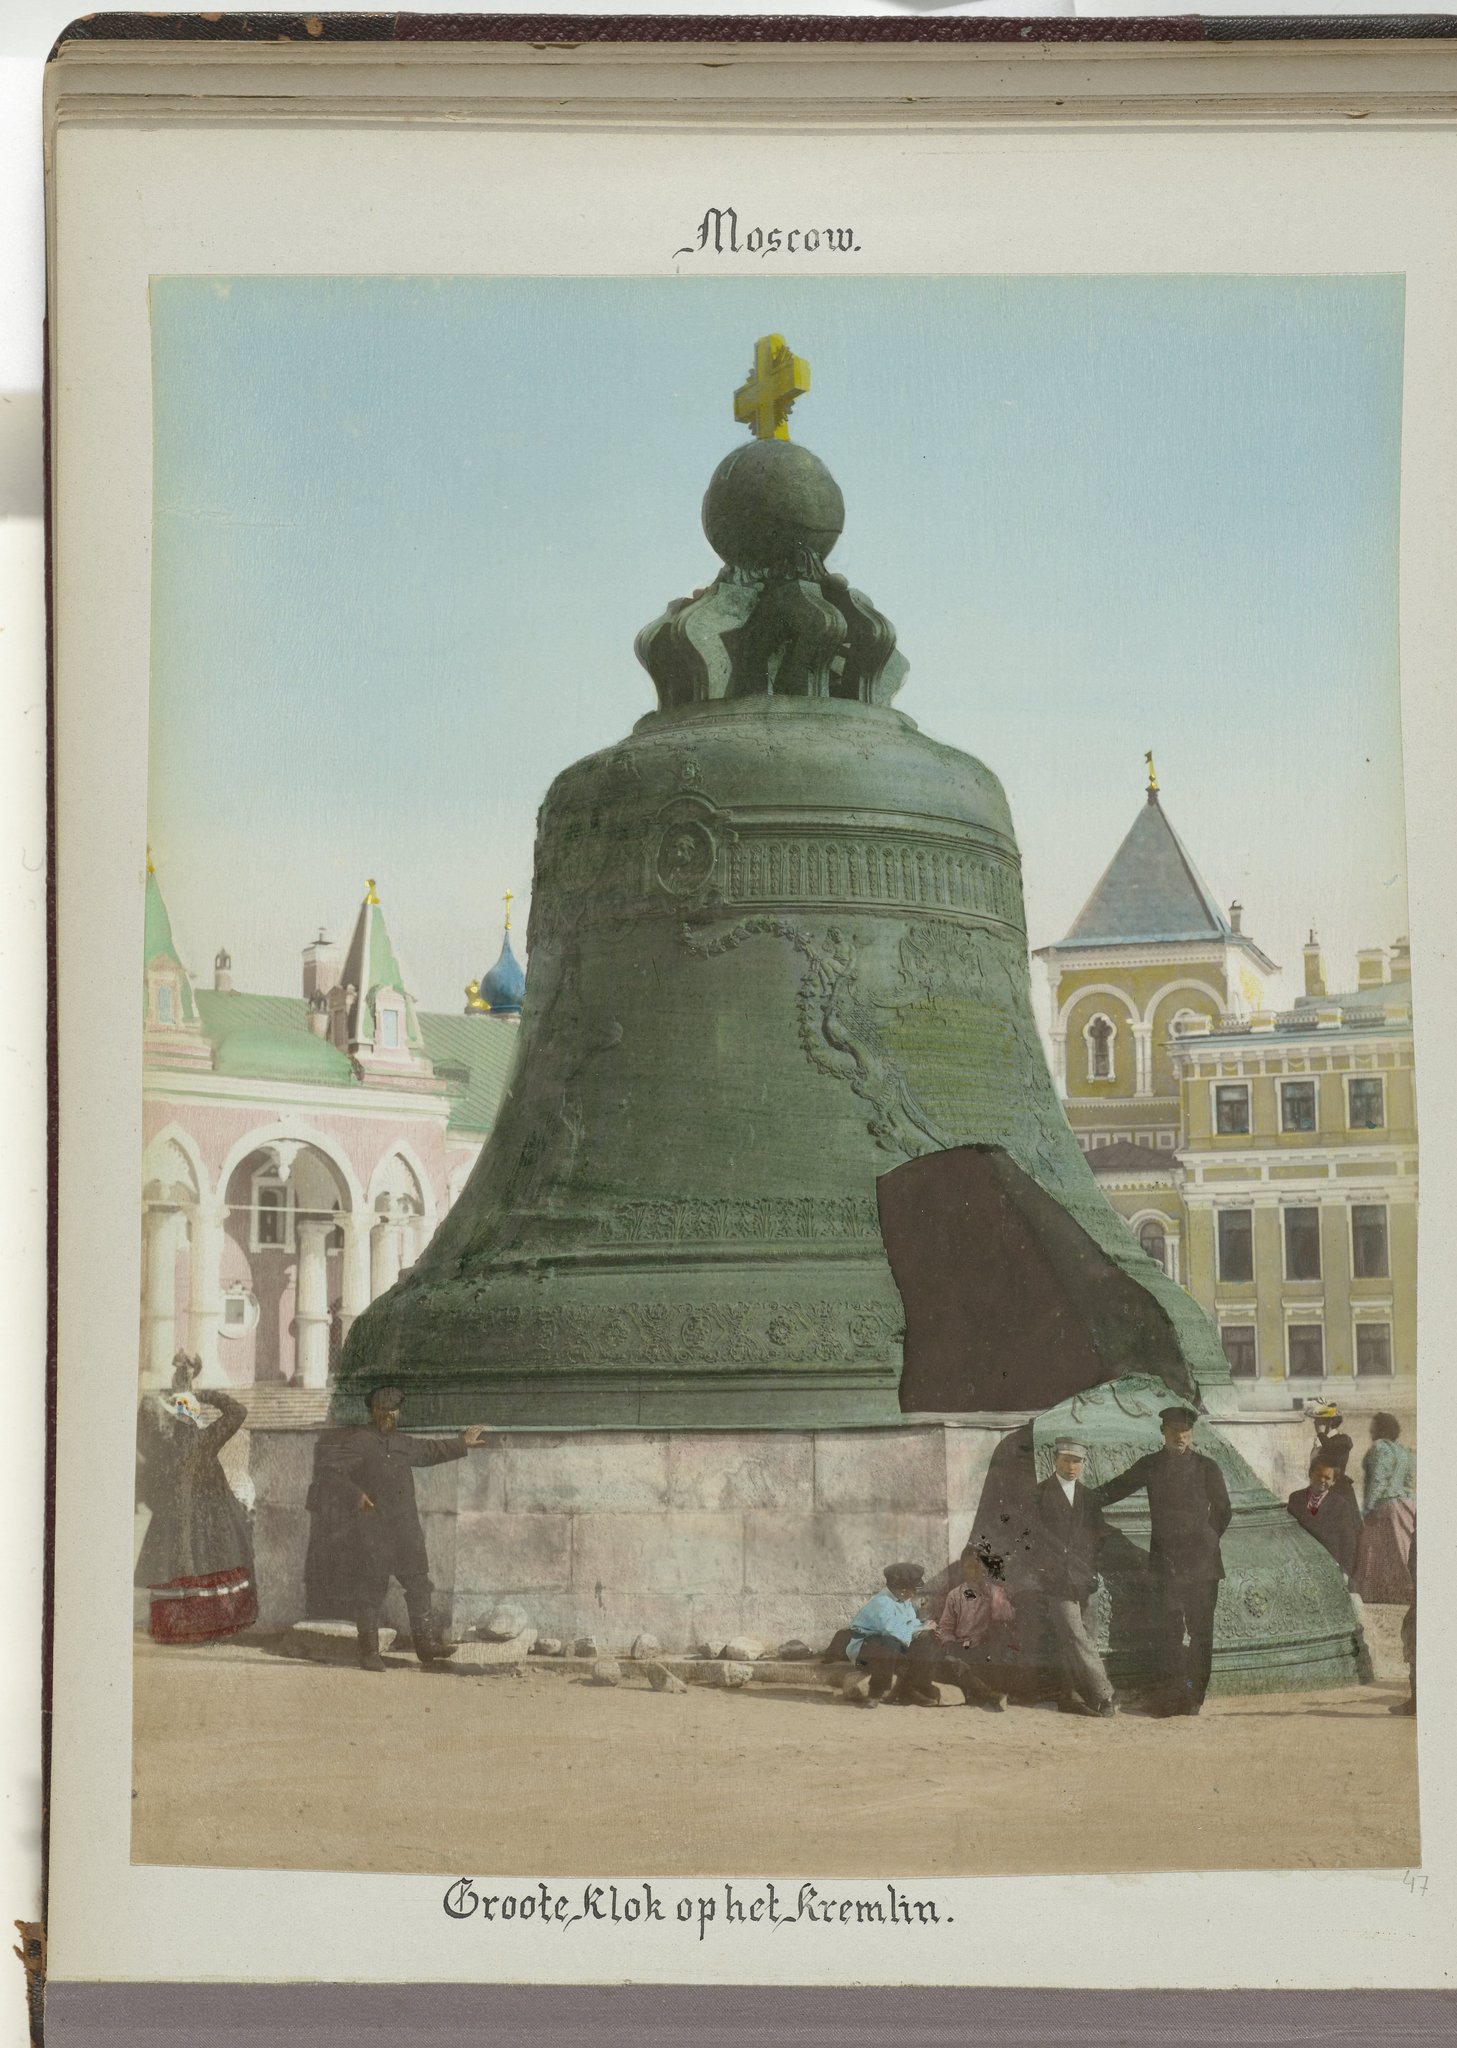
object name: photograph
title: Moscow, Groote klok op het Kremlin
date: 1898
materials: paper, photographic support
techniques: albumen print